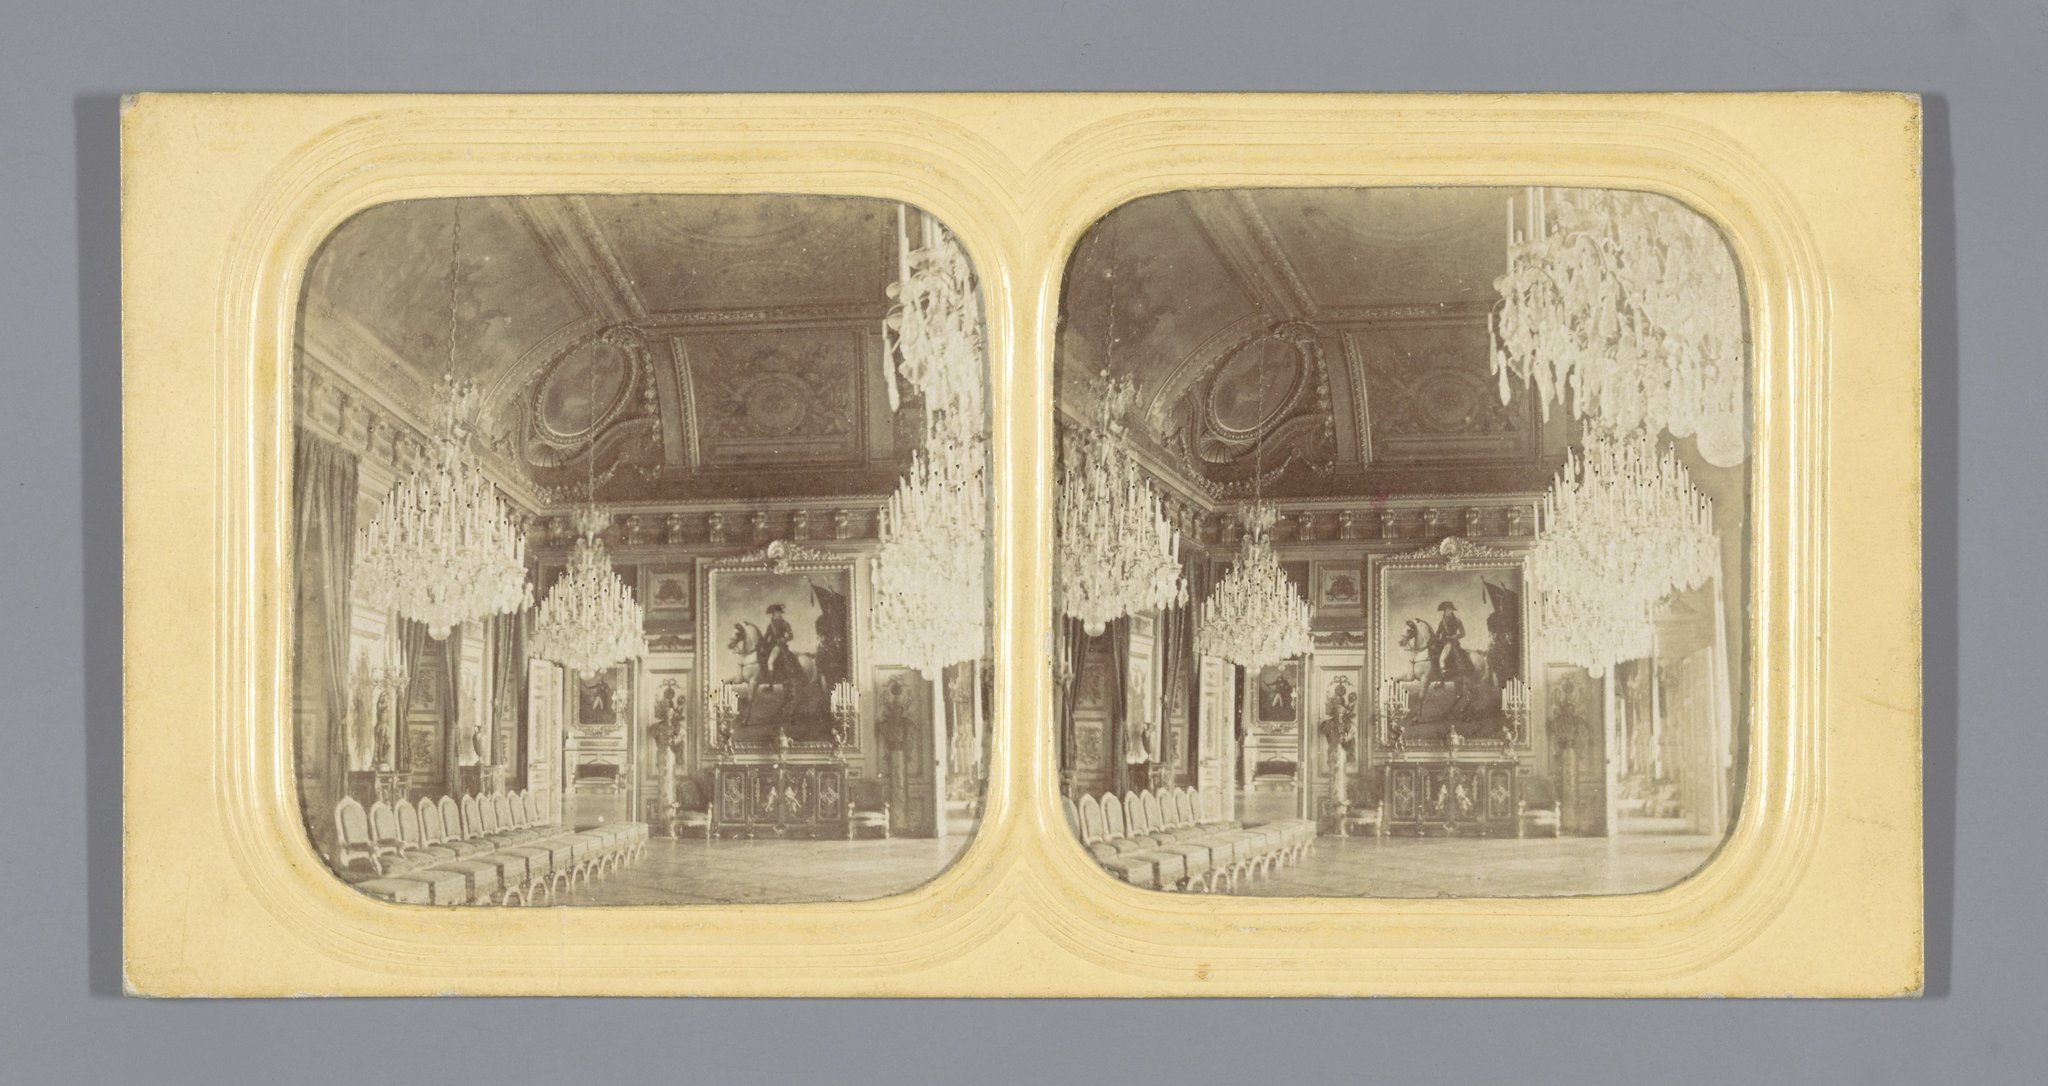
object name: tissue stereograph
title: Zaal van Napoleon of de witte salon in het Tuilerieënpaleis, Parijs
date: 1855-1860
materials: cardboard, paper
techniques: albumen print, hand coloring, perforating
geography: paris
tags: palace - aa - civic architecture: inside, tuileries palace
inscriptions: inscription: ‘Tuileries Parijs’, retailer's mark: ‘222, rue de Rivoli/ en face le Jardin des Tuileries./ Lecocq-Frêne/ Estampes Photographies/ Plans et Guides pour Voyageurs/ Vues pr Stéreoscopes.’, inscription: ‘zelf gekocht in Parijs 27 Augustus 1860.’